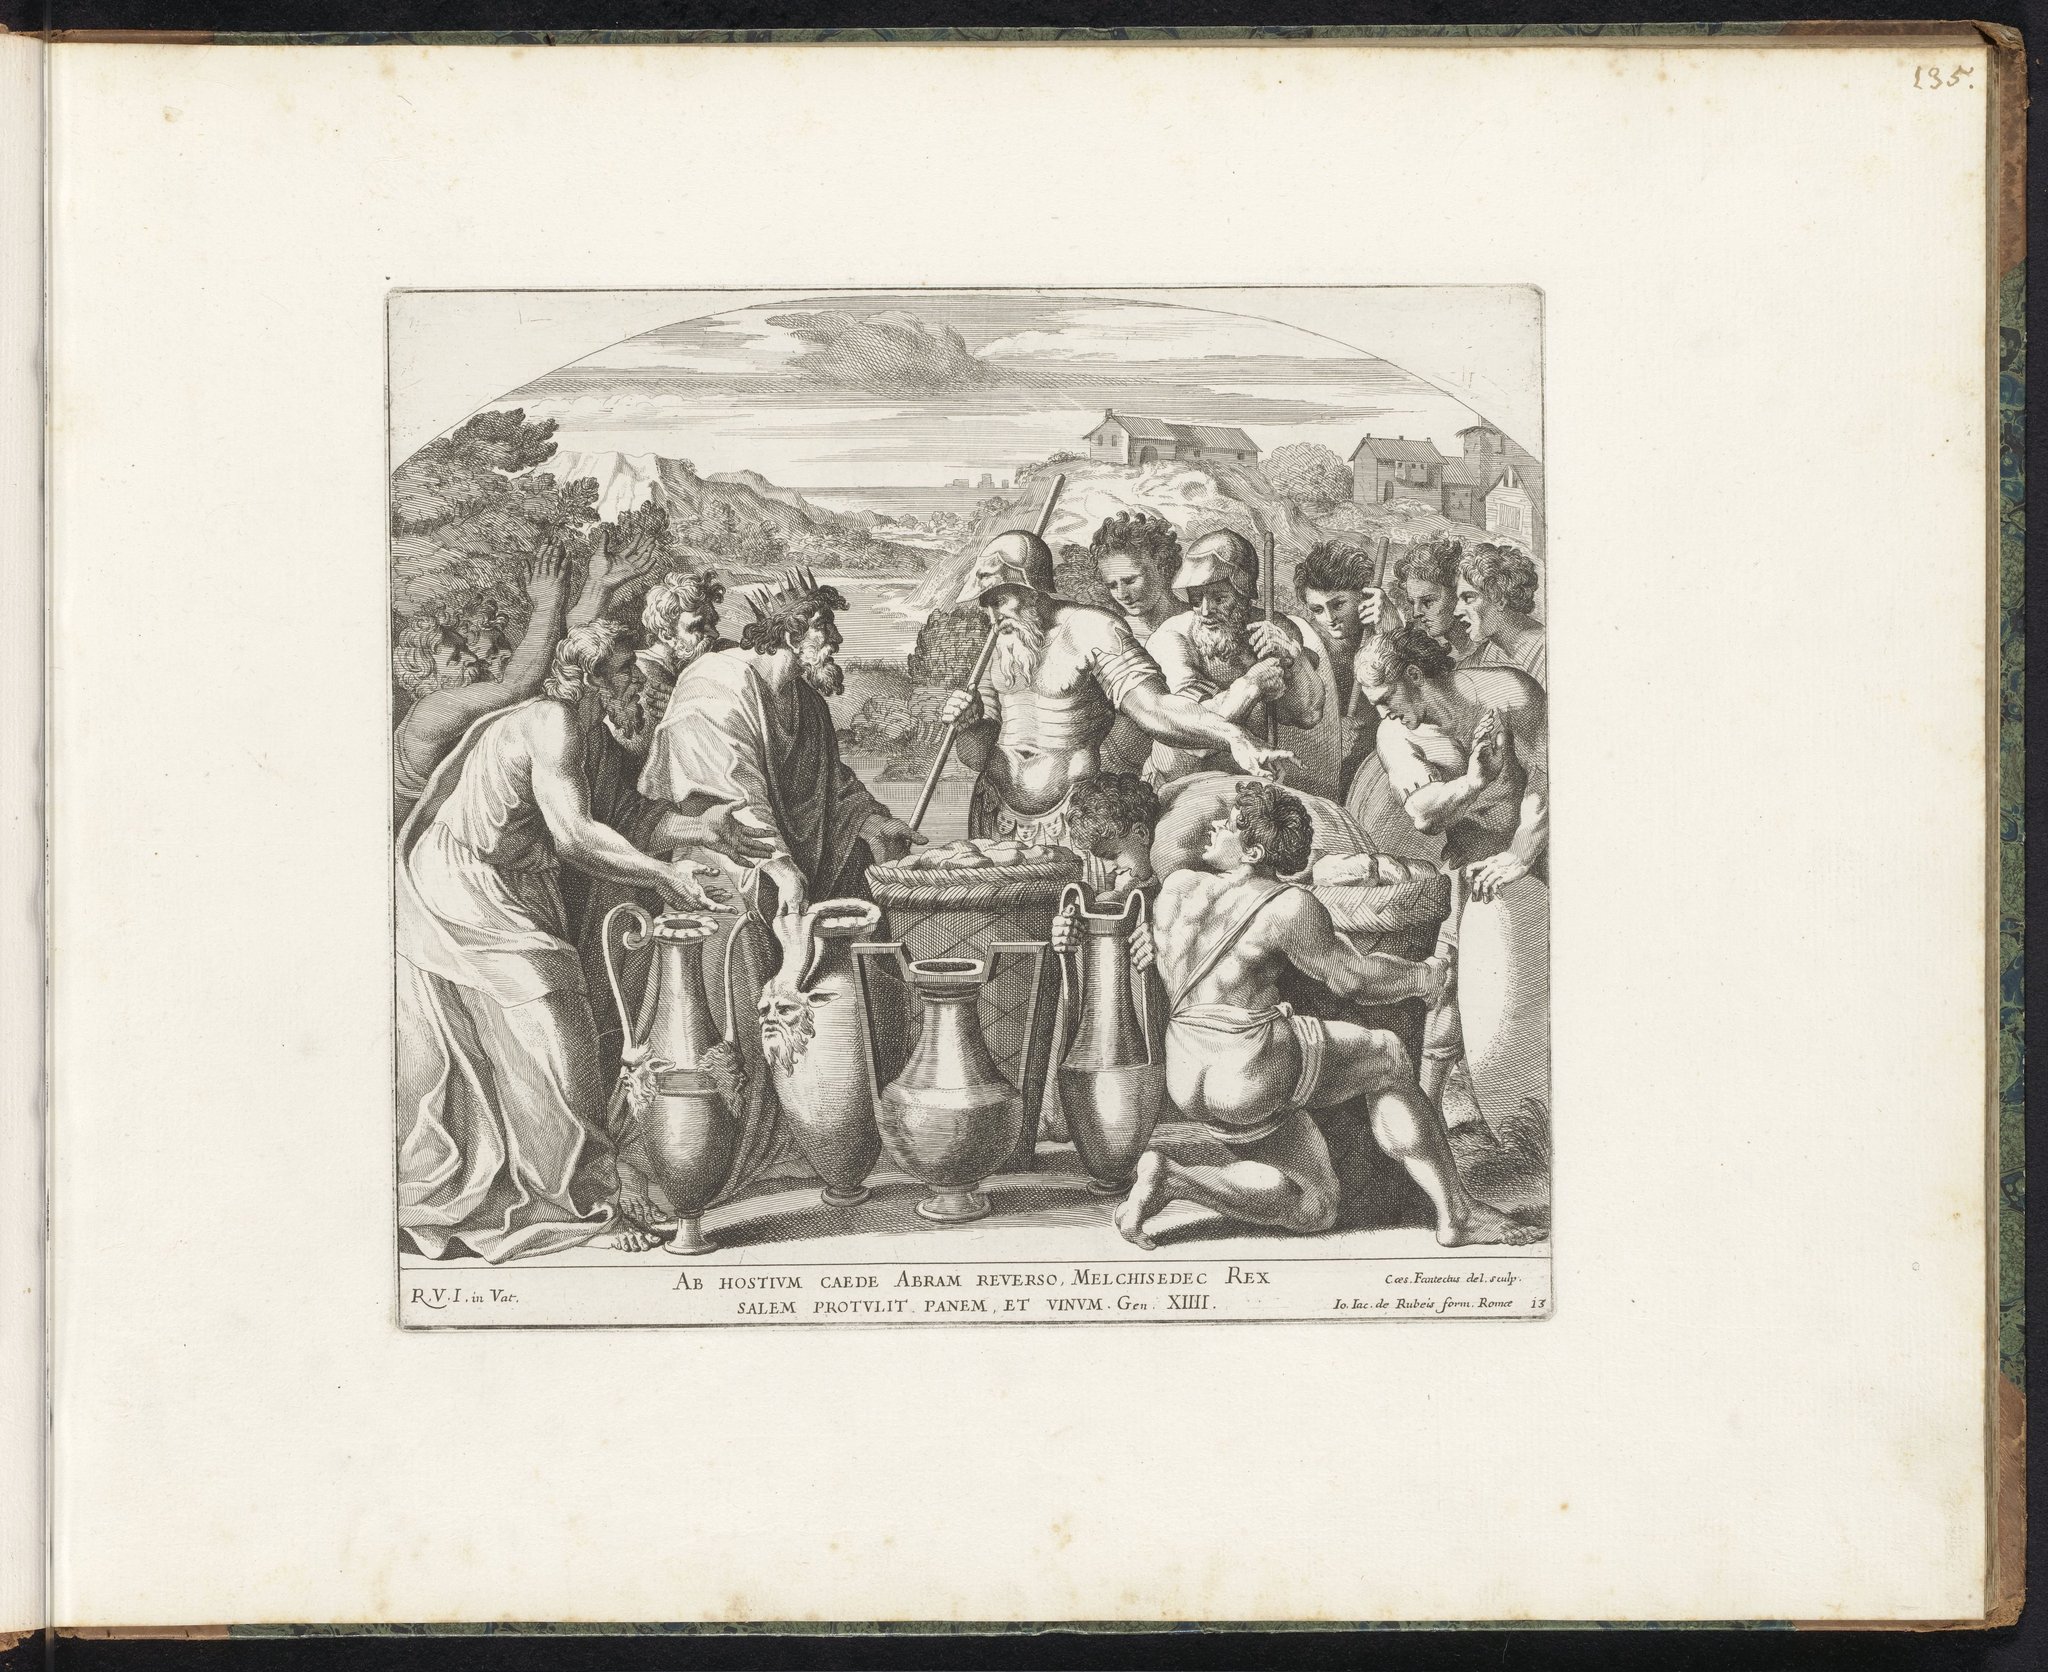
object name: album leaf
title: Rafaël Bijbel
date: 1675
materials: paper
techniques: etching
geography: rome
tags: the meeting of abraham and melchizedek, the high priest and king of salem, who brings bread and wine (genesis 14:18-20)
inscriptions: number: ‘135’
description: Abraham en zijn mannen worden verwelkomd door Melchisedek, de koning en hogepriester van Salem. Melchisedek biedt Ambraham brood en wijn aan. Bijbelvers onder de voorstelling. Prent maakt deel uit van een album.